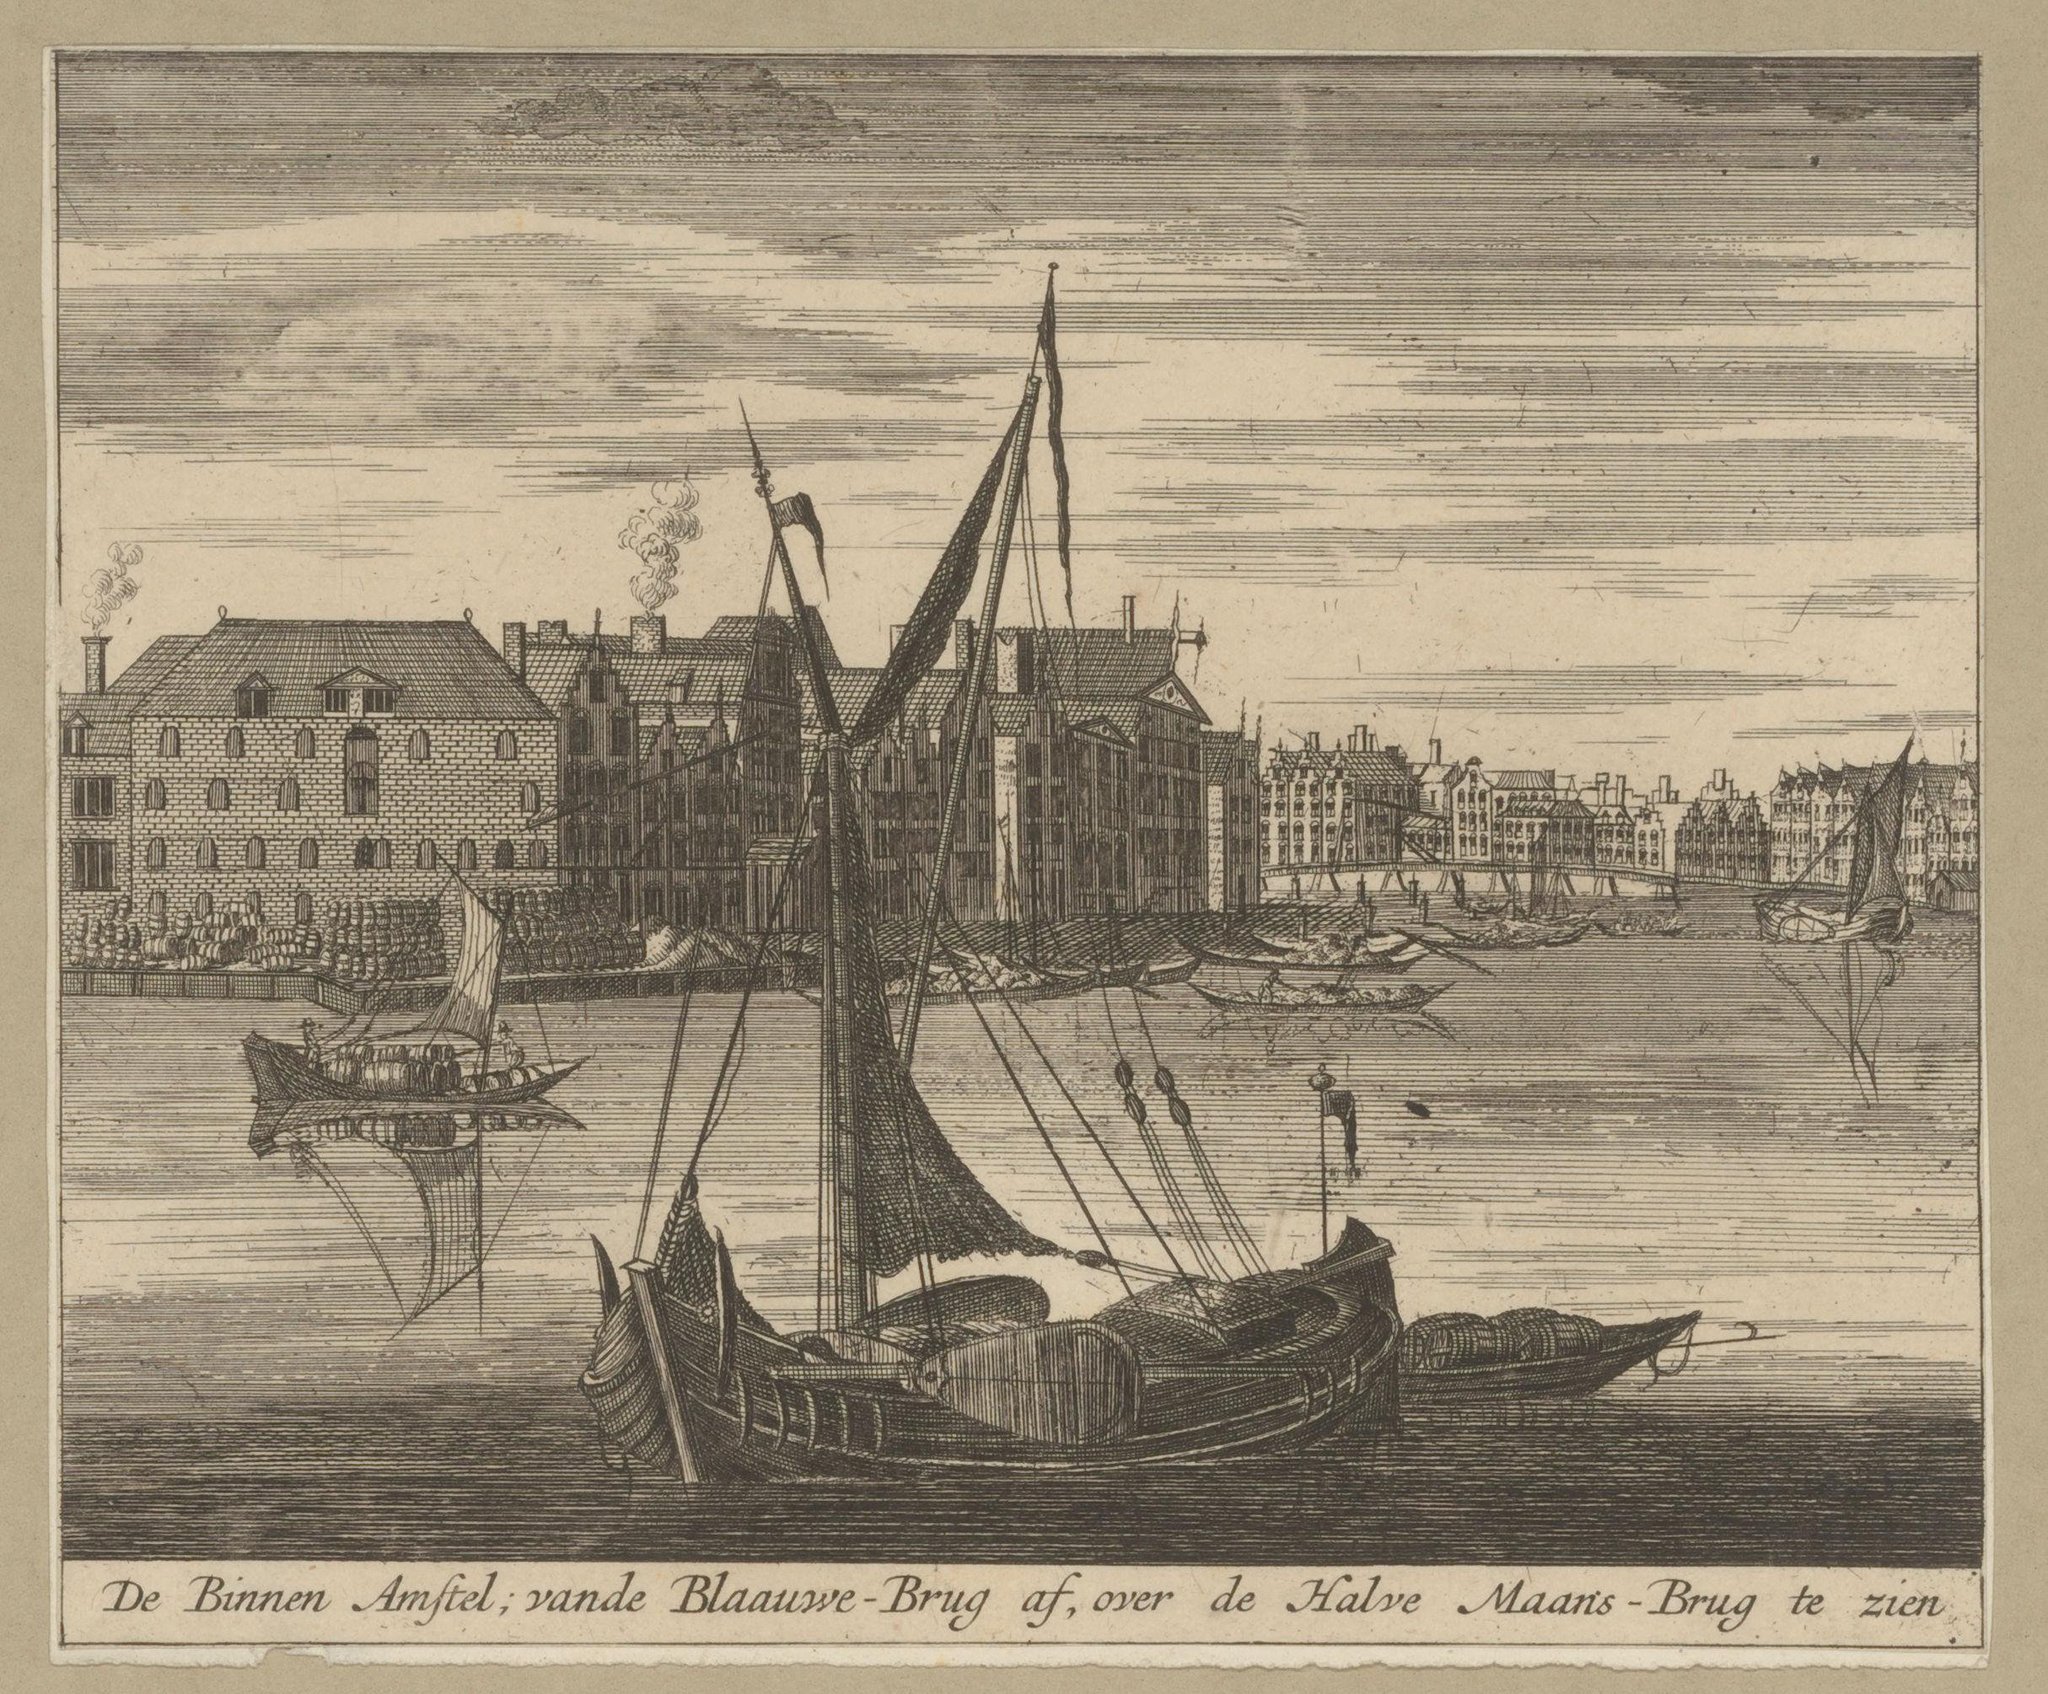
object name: print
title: De Binnen-Amstel, van de Blaauwe-brugh af, over de Halve-Maans-brugh te zien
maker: Anonymous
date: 1700-1799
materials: paper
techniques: etching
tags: city-view in general; 'veduta', canal, ships (in general) - cc - more than one ship, bridge in city across river, canal, etc.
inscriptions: collector's mark: ‘4A-37 a en b’ Lugt 1641b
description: Onderwerpsrubriek binnen de Atlas Amsterdam: Amstel van Doelensluis tot Blauwbrug.